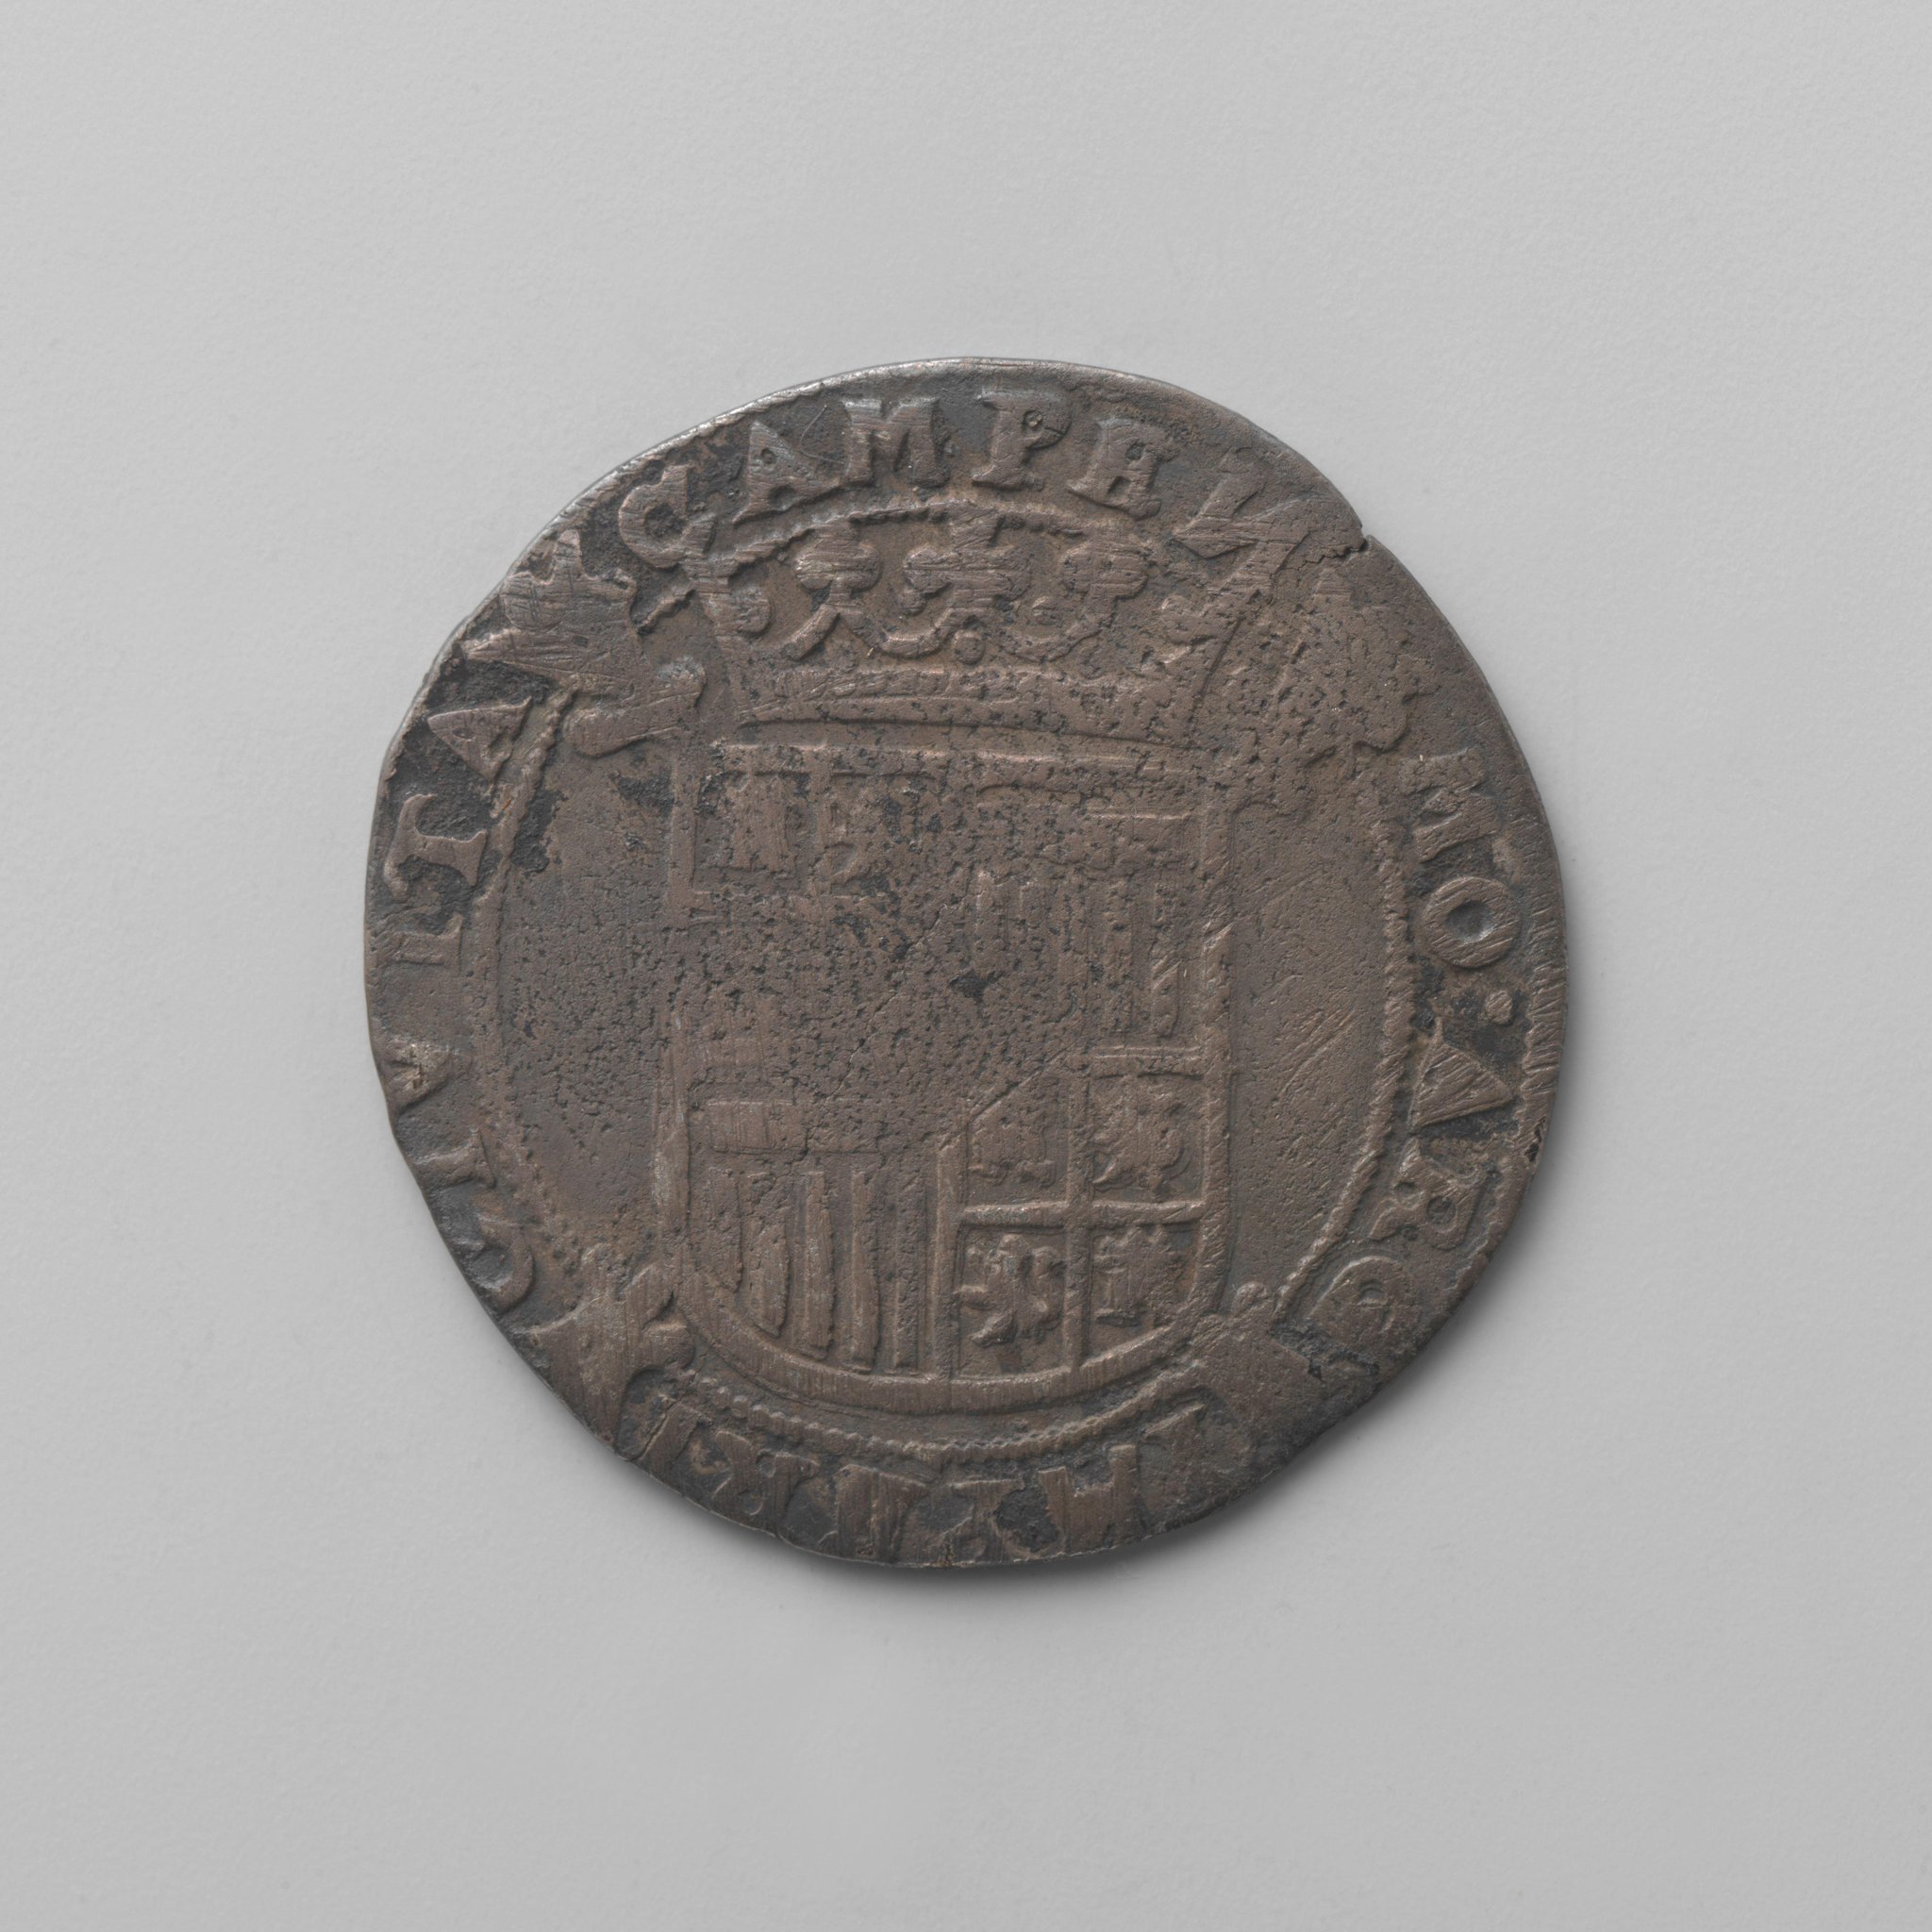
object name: coin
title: Kampen, arendsschelling met naam van keizer Matthias I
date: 1610-1630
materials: silver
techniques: striking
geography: kampen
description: Zilveren munt. Voorzijde: gekroond vereenvoudigd Spaans wapenschild. Keerzijde: gekroonde dubbelkoppige adelaar.